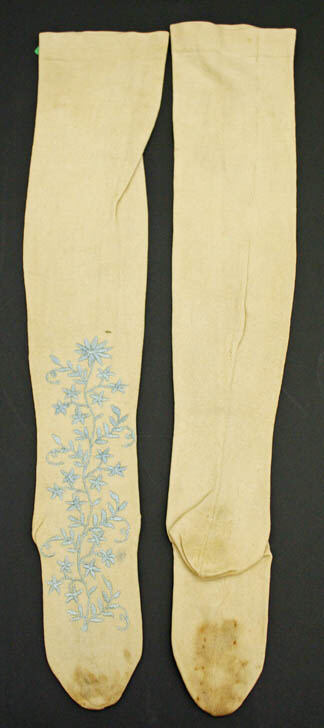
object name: stocking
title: Stockings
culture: american or european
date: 1767-1800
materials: cotton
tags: plants